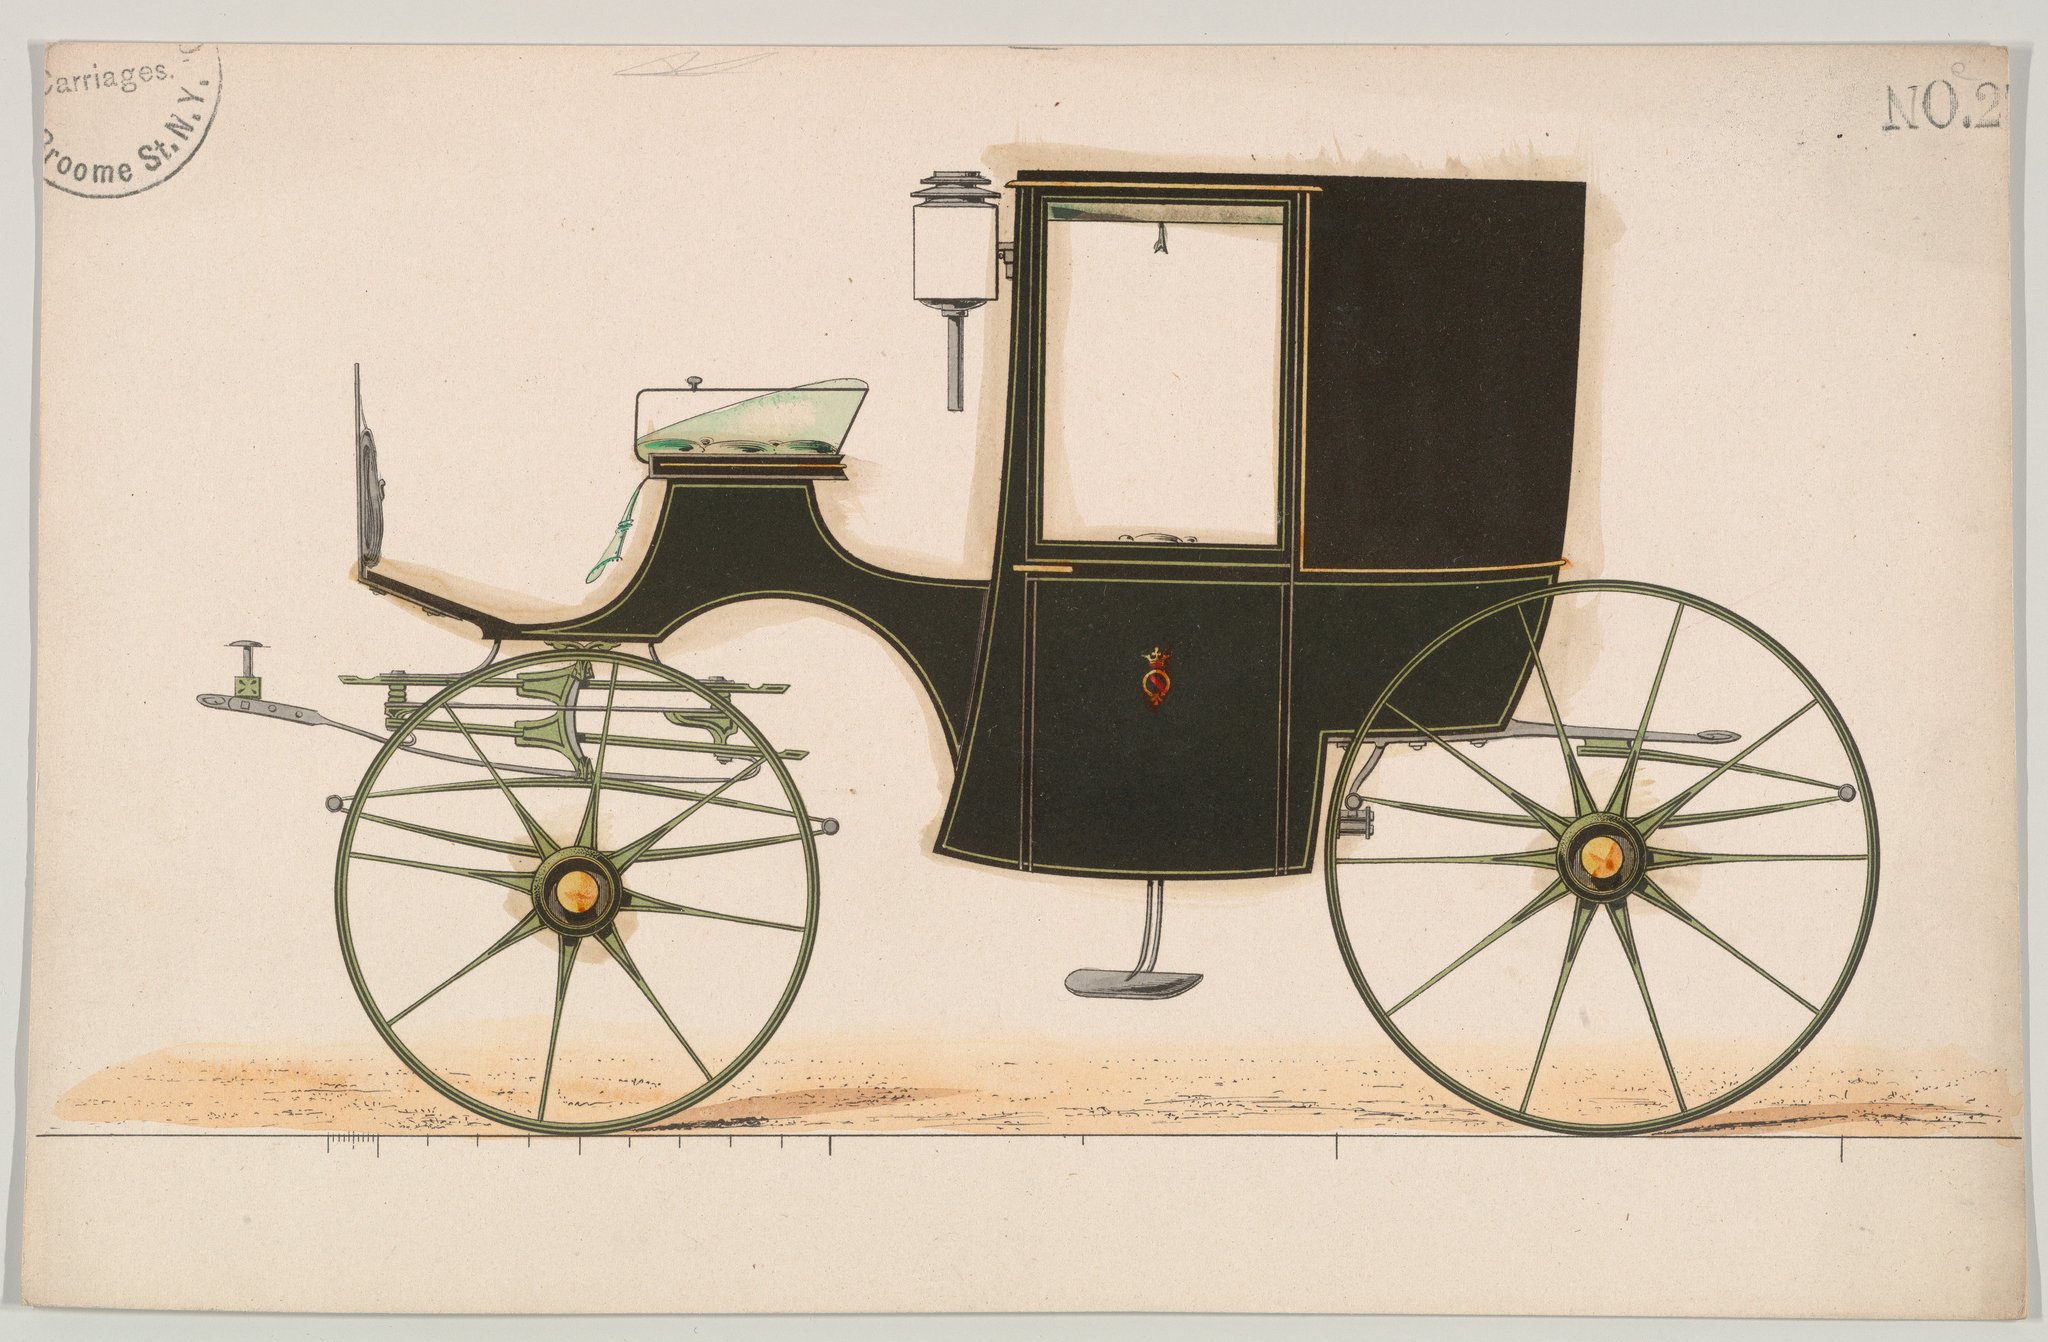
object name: drawing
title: Coupe or Brougham (unnumbered)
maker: brewster & co.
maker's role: manufacturer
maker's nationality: american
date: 1850-1870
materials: gouache, gum arabic, ink, watercolor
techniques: pen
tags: carriages